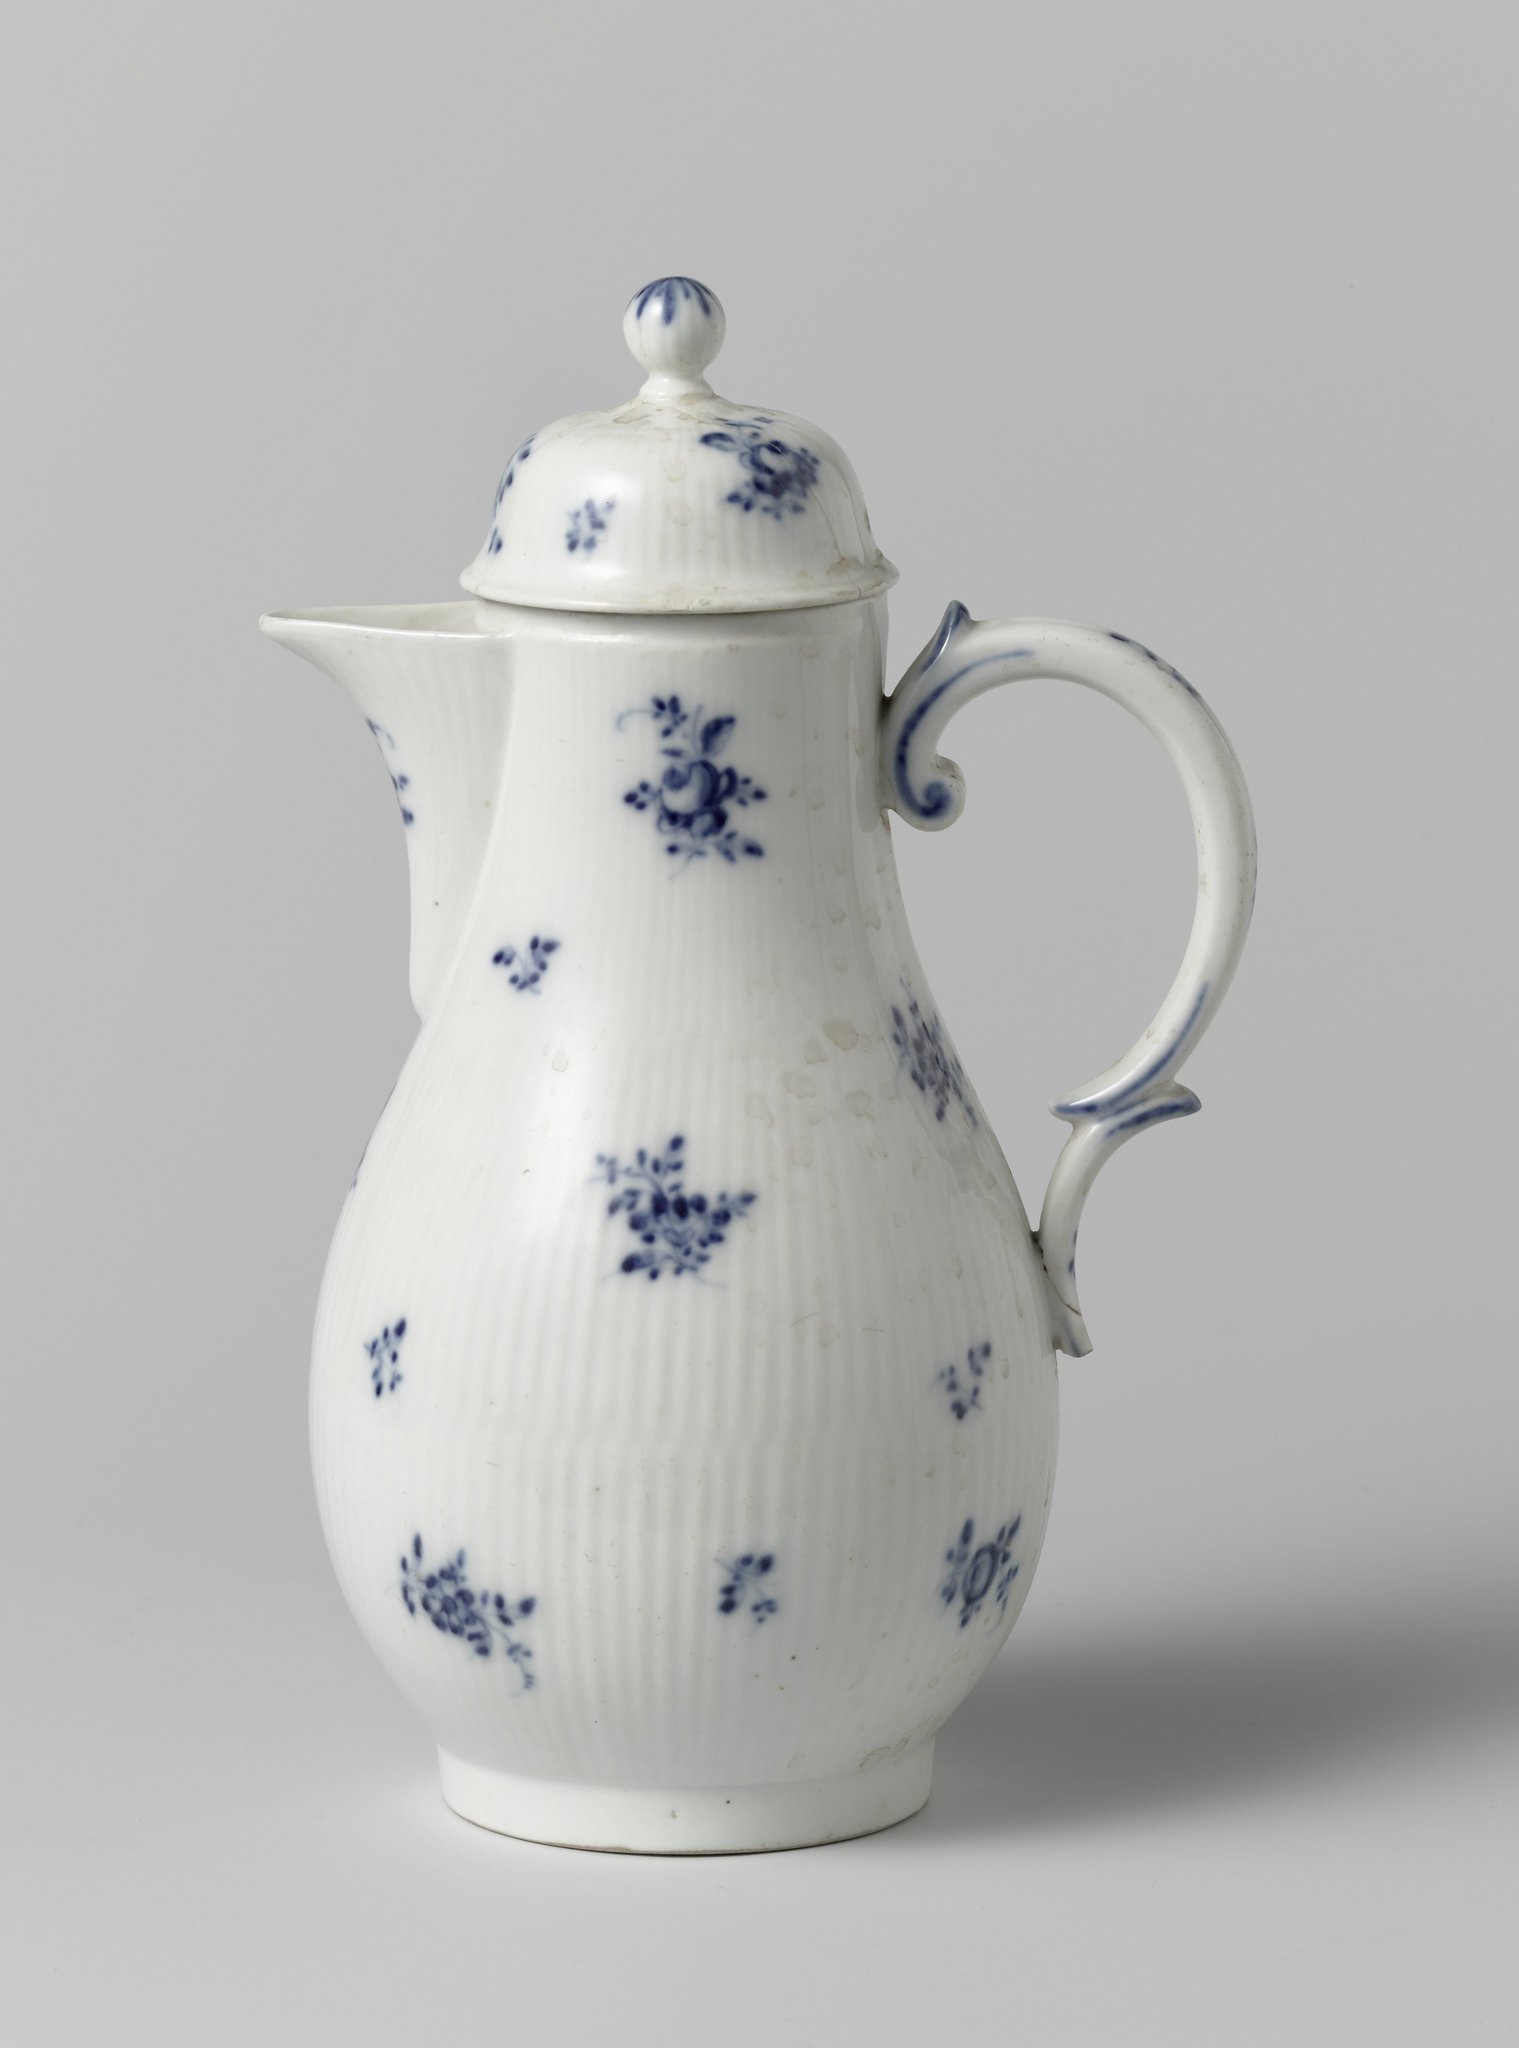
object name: milk jug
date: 1784-1790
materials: porcelain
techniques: painted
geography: loosdrecht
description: Porceleinfabriek aan den Amstel Manufactuur Oud-Loosdrecht Ouder-Amstel and Loosdrecht, c. 1784–1790 hard-paste porcelain